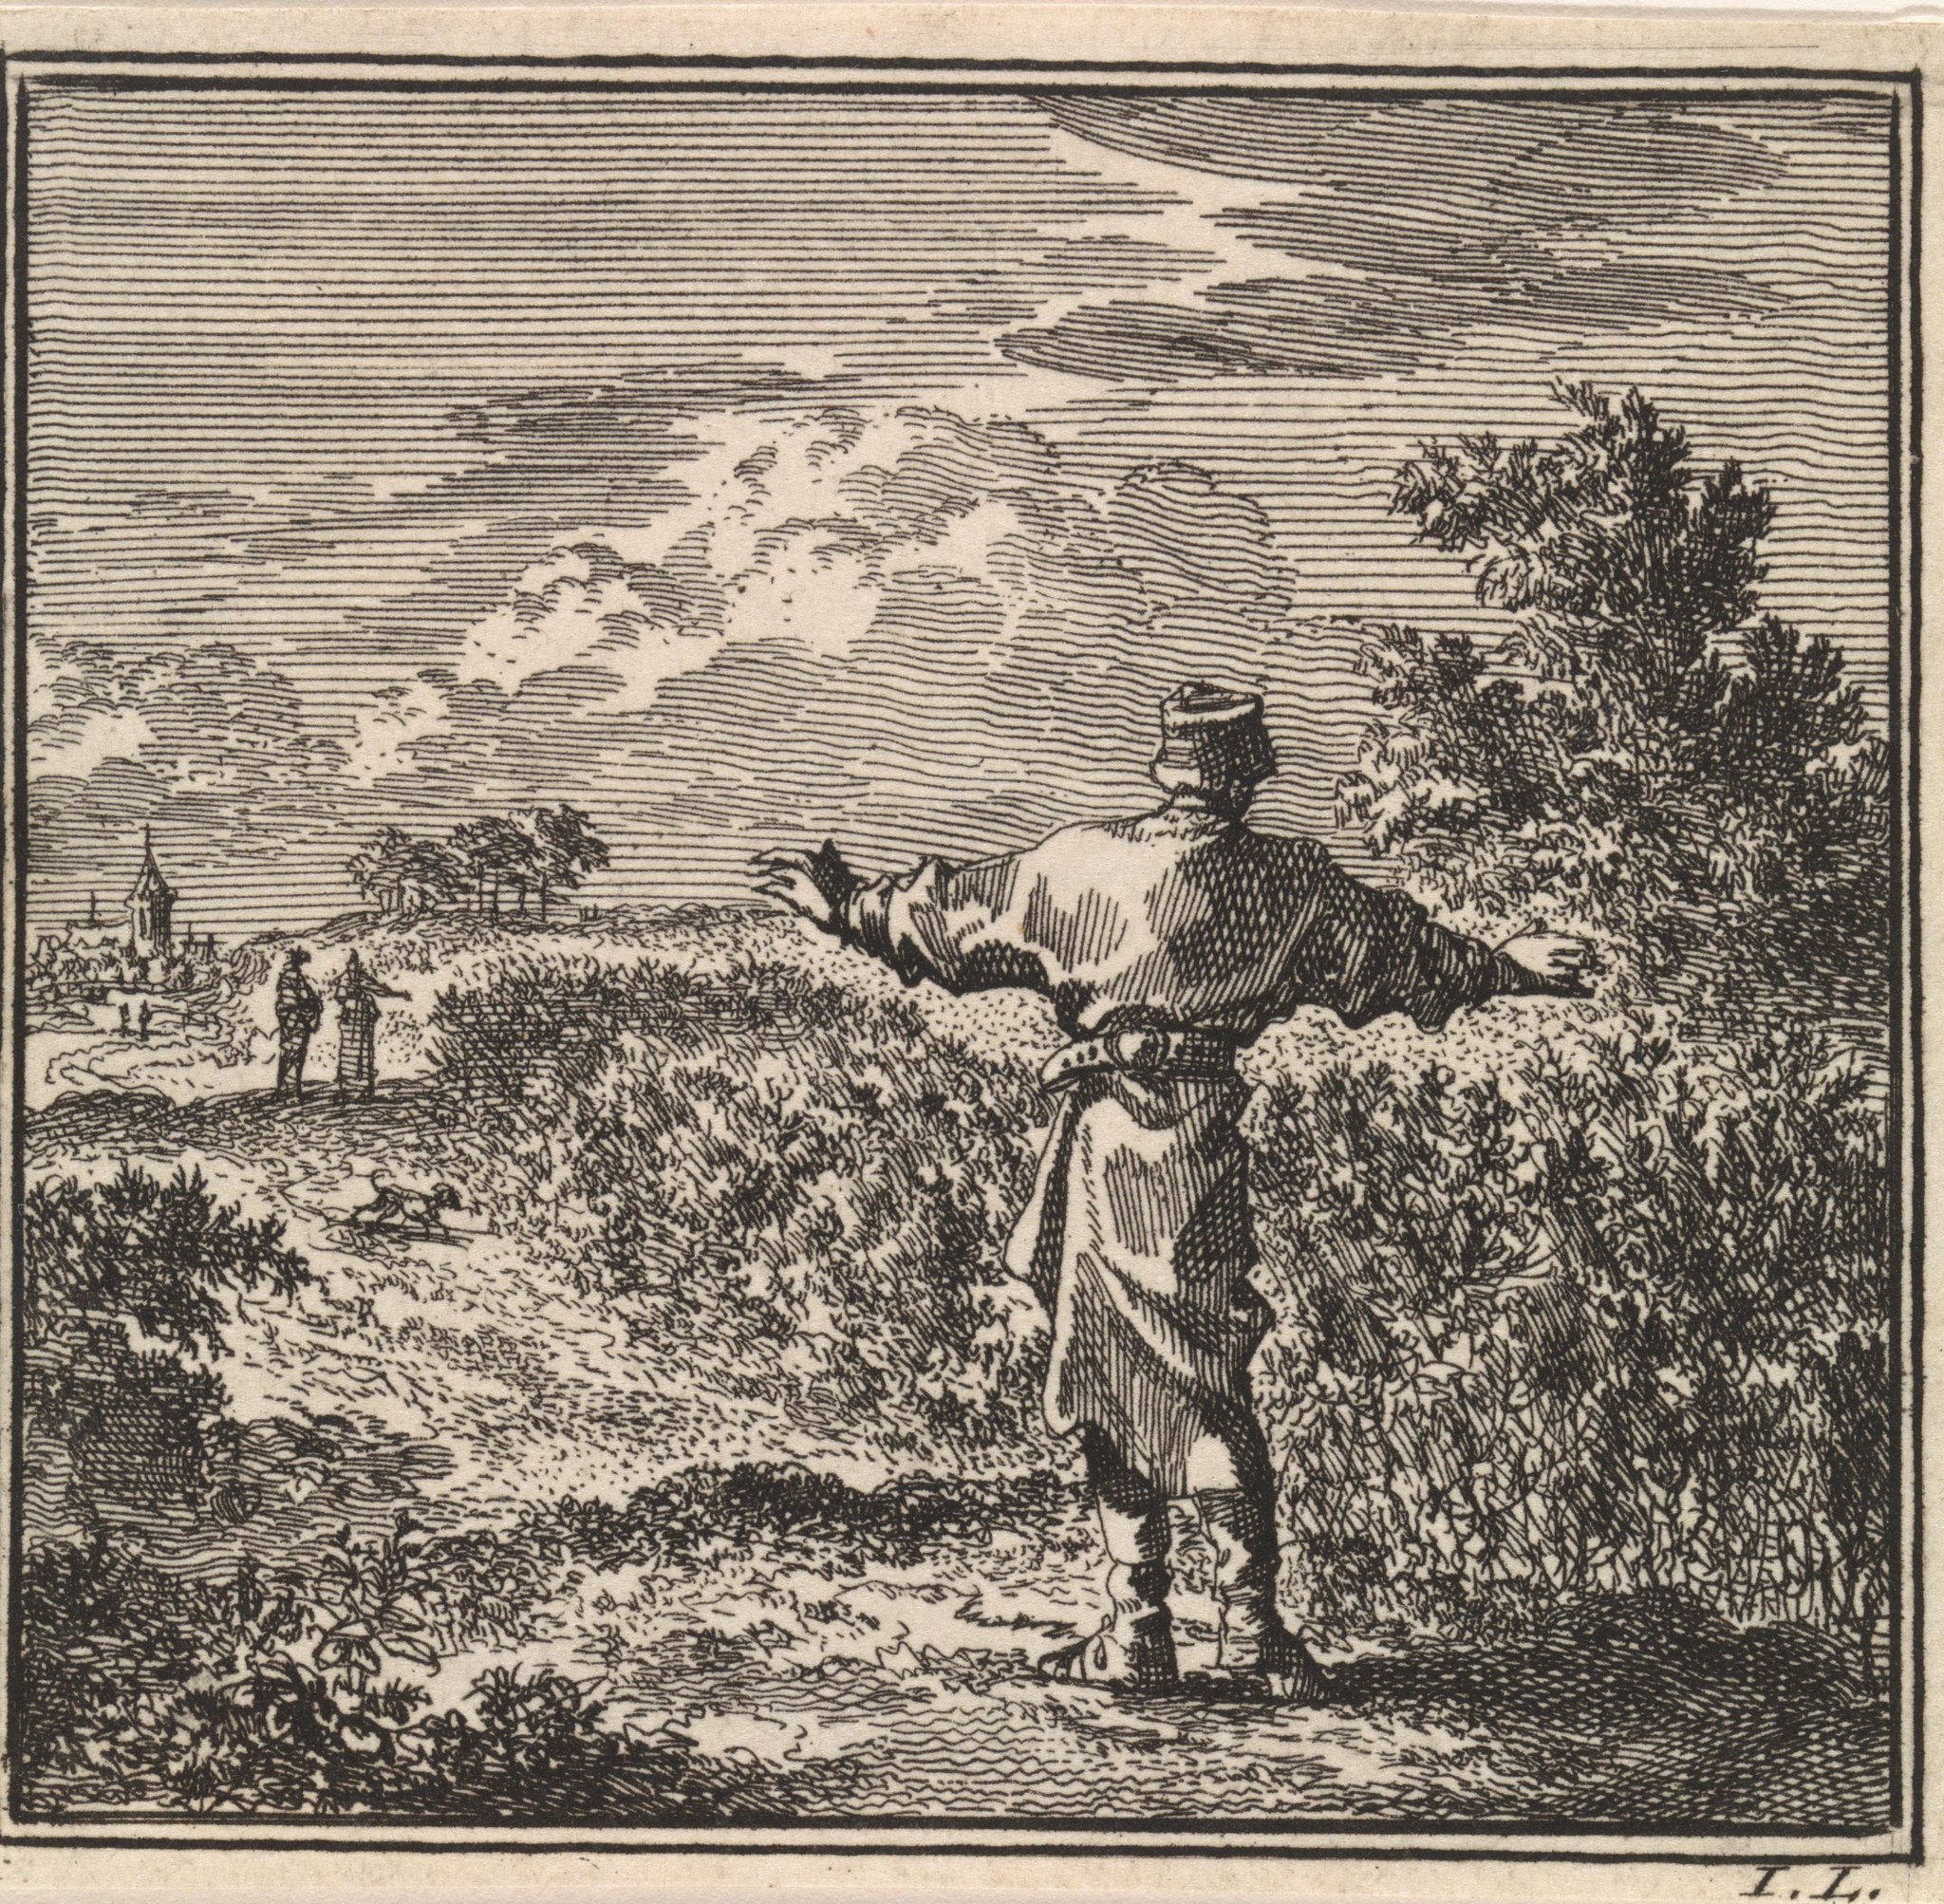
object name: book illustration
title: Man kijkt uit over een koolzaadveld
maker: jan luyken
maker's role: draughtsman, print maker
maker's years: 1649-1712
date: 1711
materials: paper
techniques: etching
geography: amsterdam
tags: field filled with a crop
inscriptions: collector's mark: Lugt 2228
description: Illustratie voor: Luyken, Jan. De Bykorf des Gemoeds. Amsterdam: Pieter Arentsz. II (wed.) en Cornelis van der Sys, 1711, p. 382.